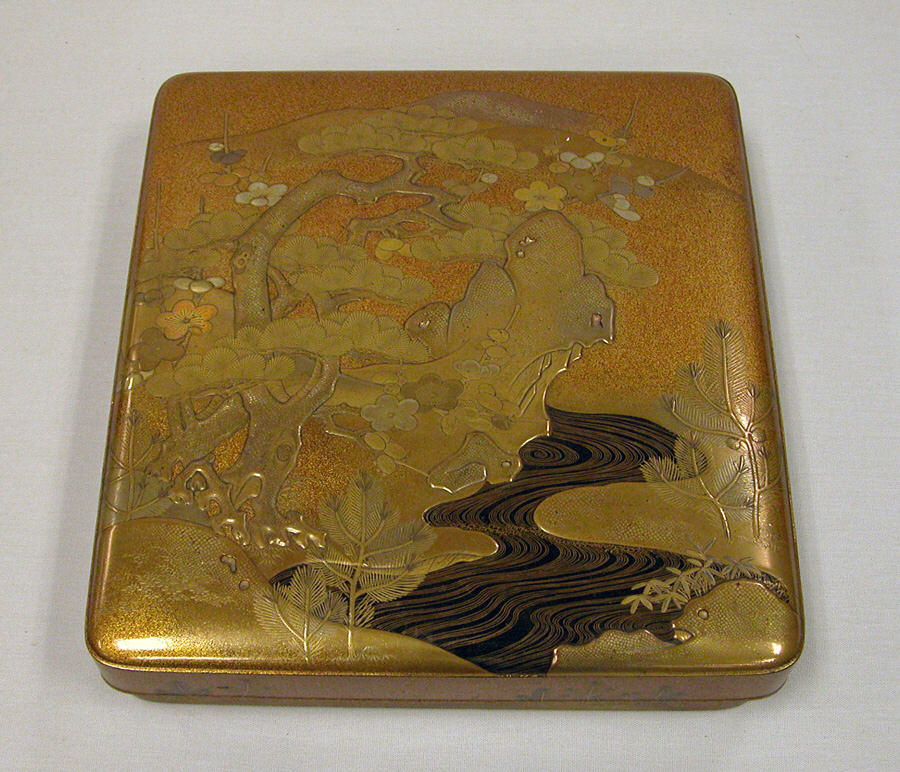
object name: writing box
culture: japanese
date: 1701-1800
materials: gold, lacquer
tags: trees,streams